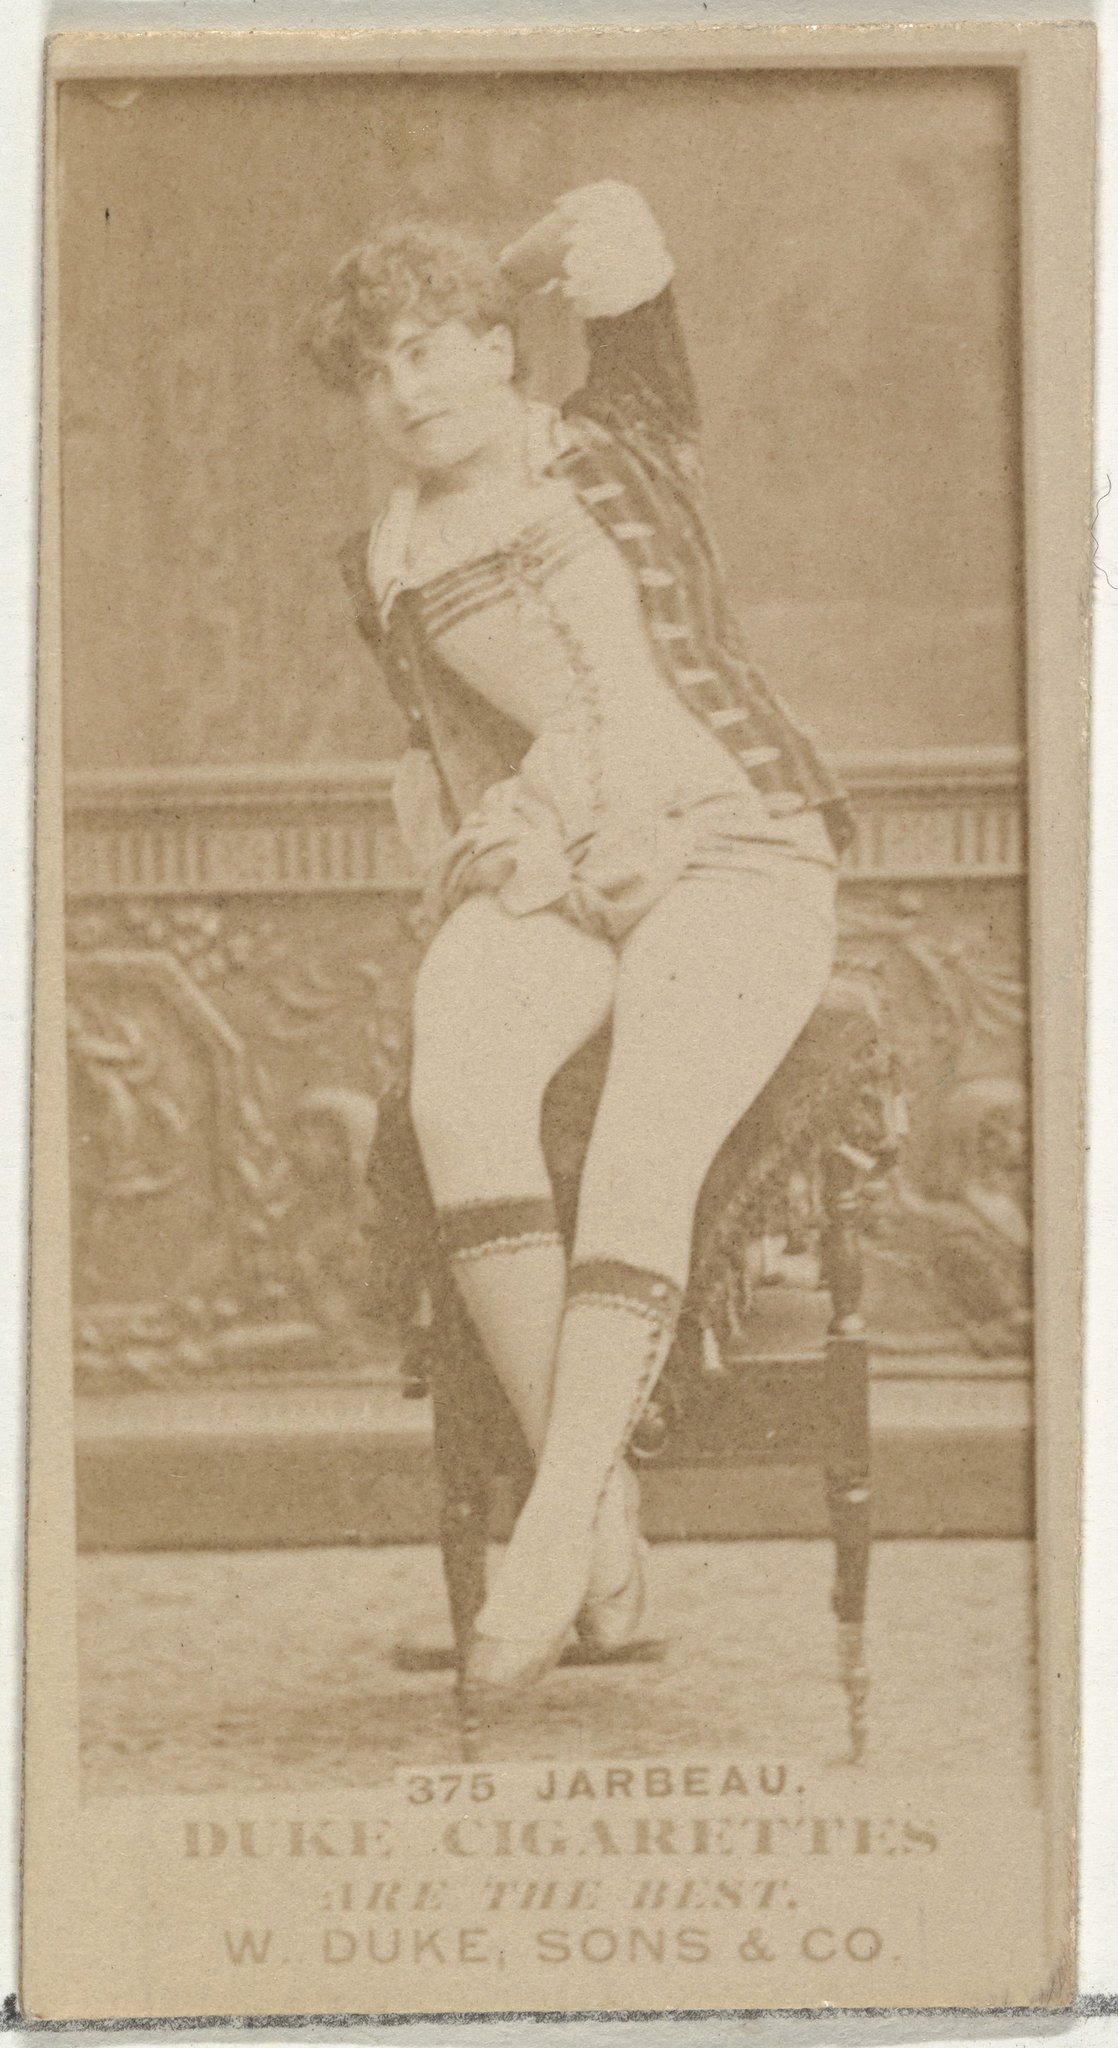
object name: photograph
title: Card Number 375, Miss Jarbeau, from the Actors and Actresses series (N145-7) issued by Duke Sons & Co. to promote Duke Cigarettes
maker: w. duke, sons & co.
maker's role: publisher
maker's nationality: american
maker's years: 1870-1920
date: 1880-1889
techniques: albumen silver print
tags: portraits,women,actresses